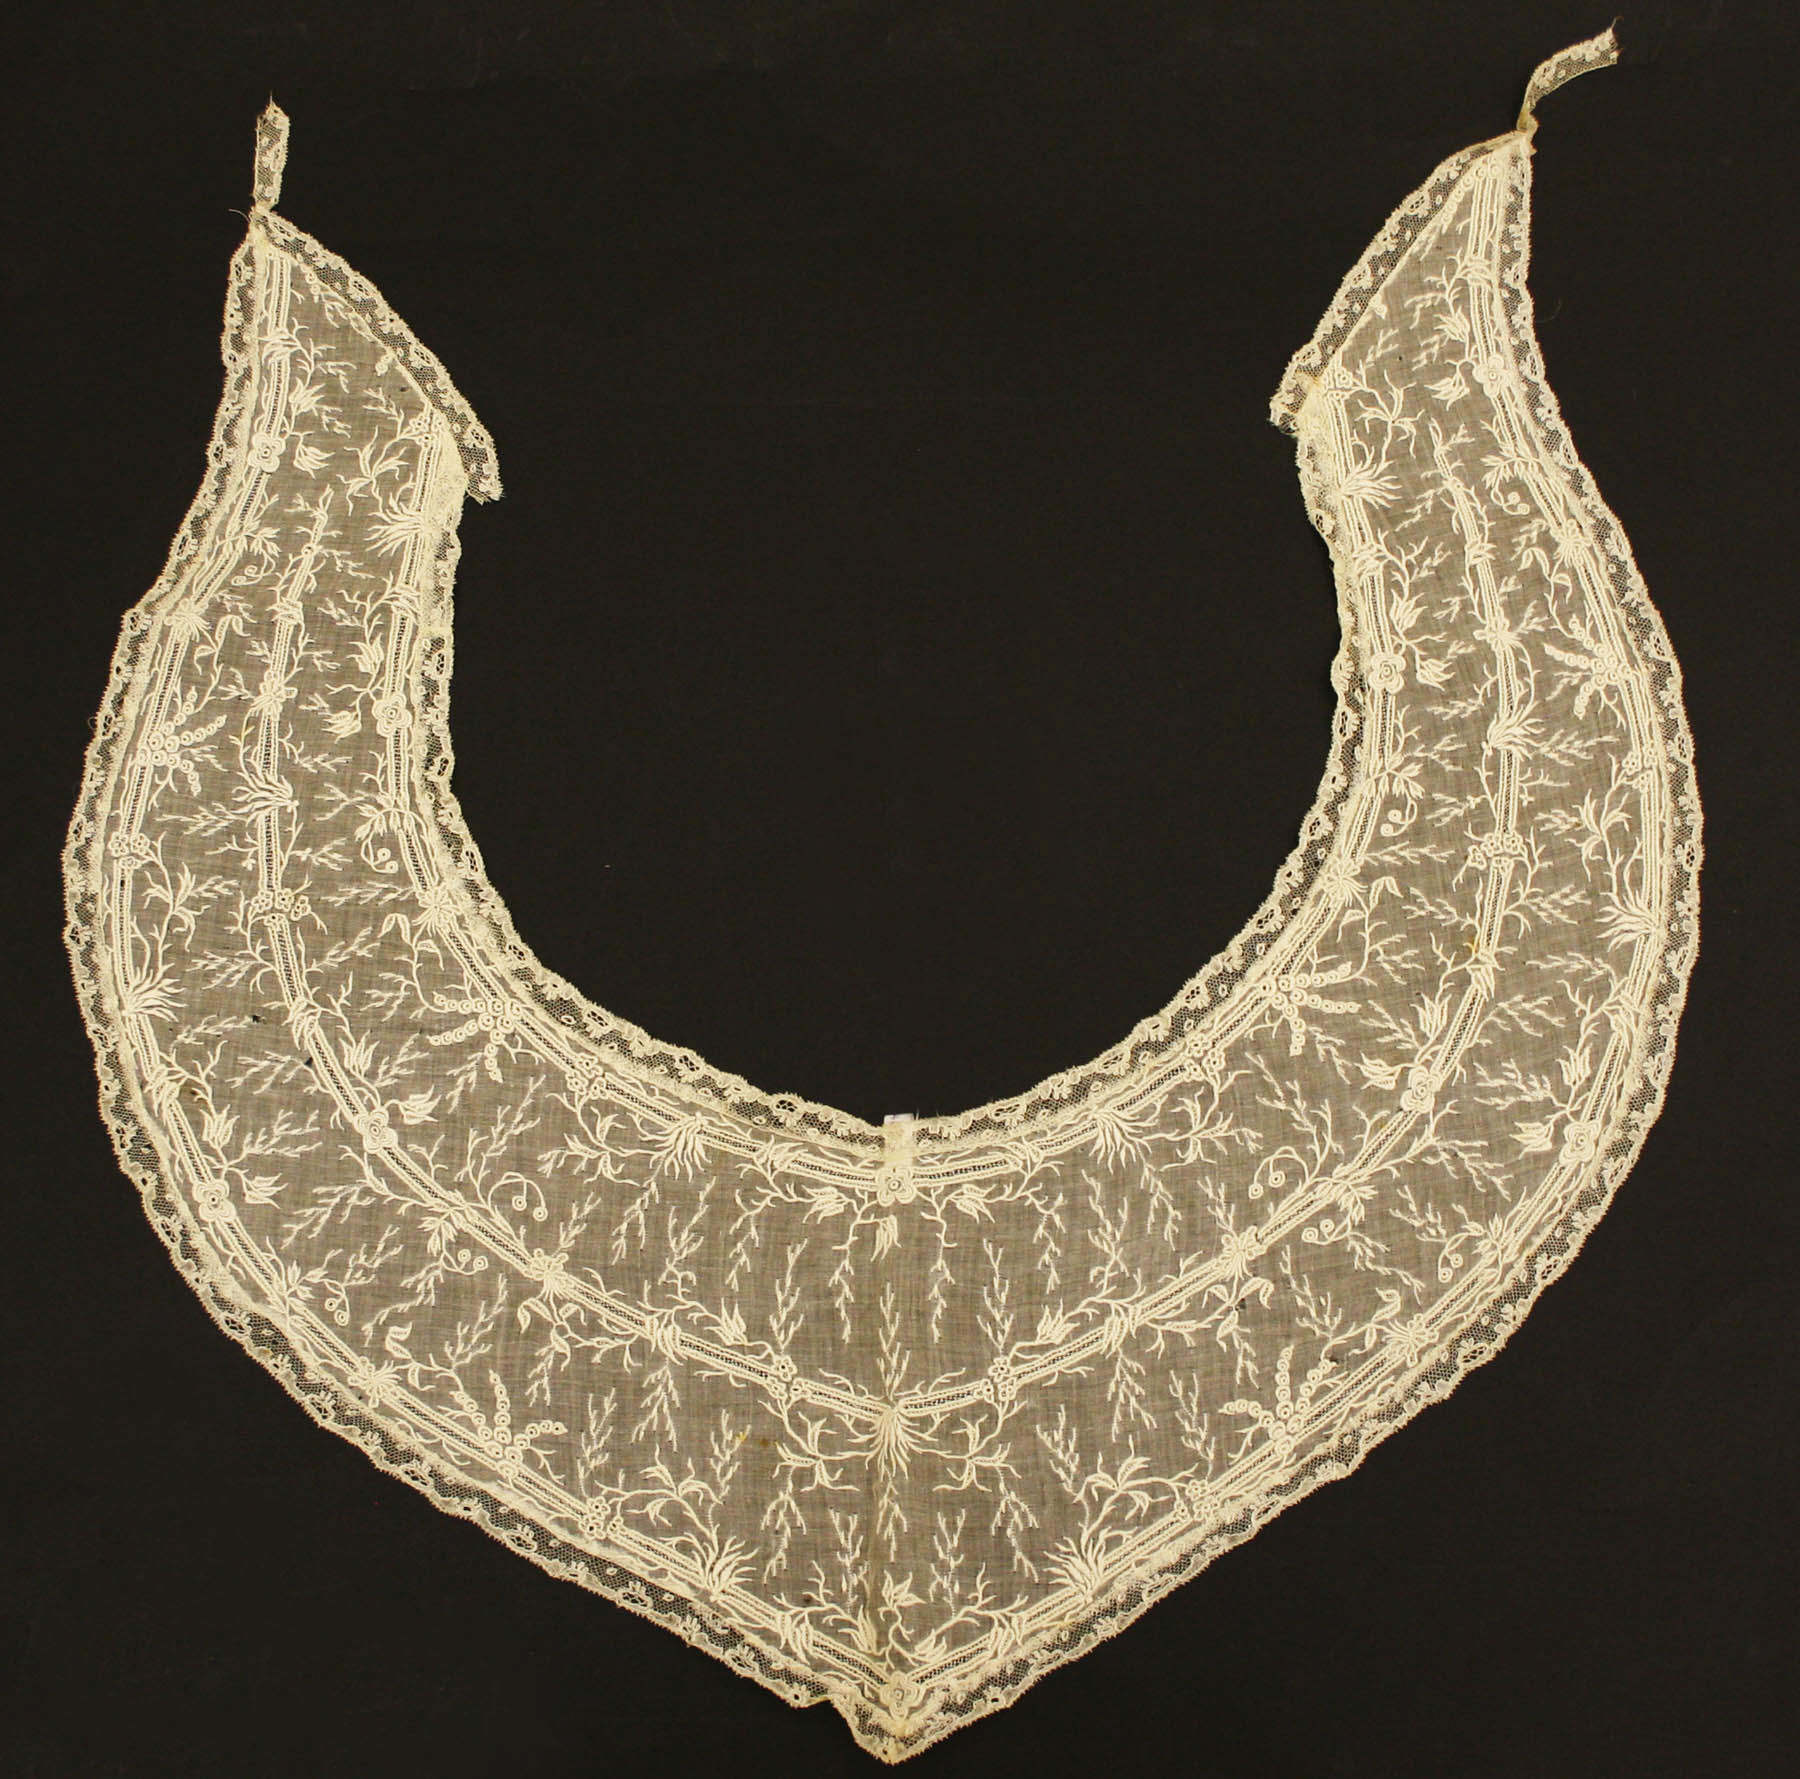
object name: collar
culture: american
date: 1840-1849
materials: cotton